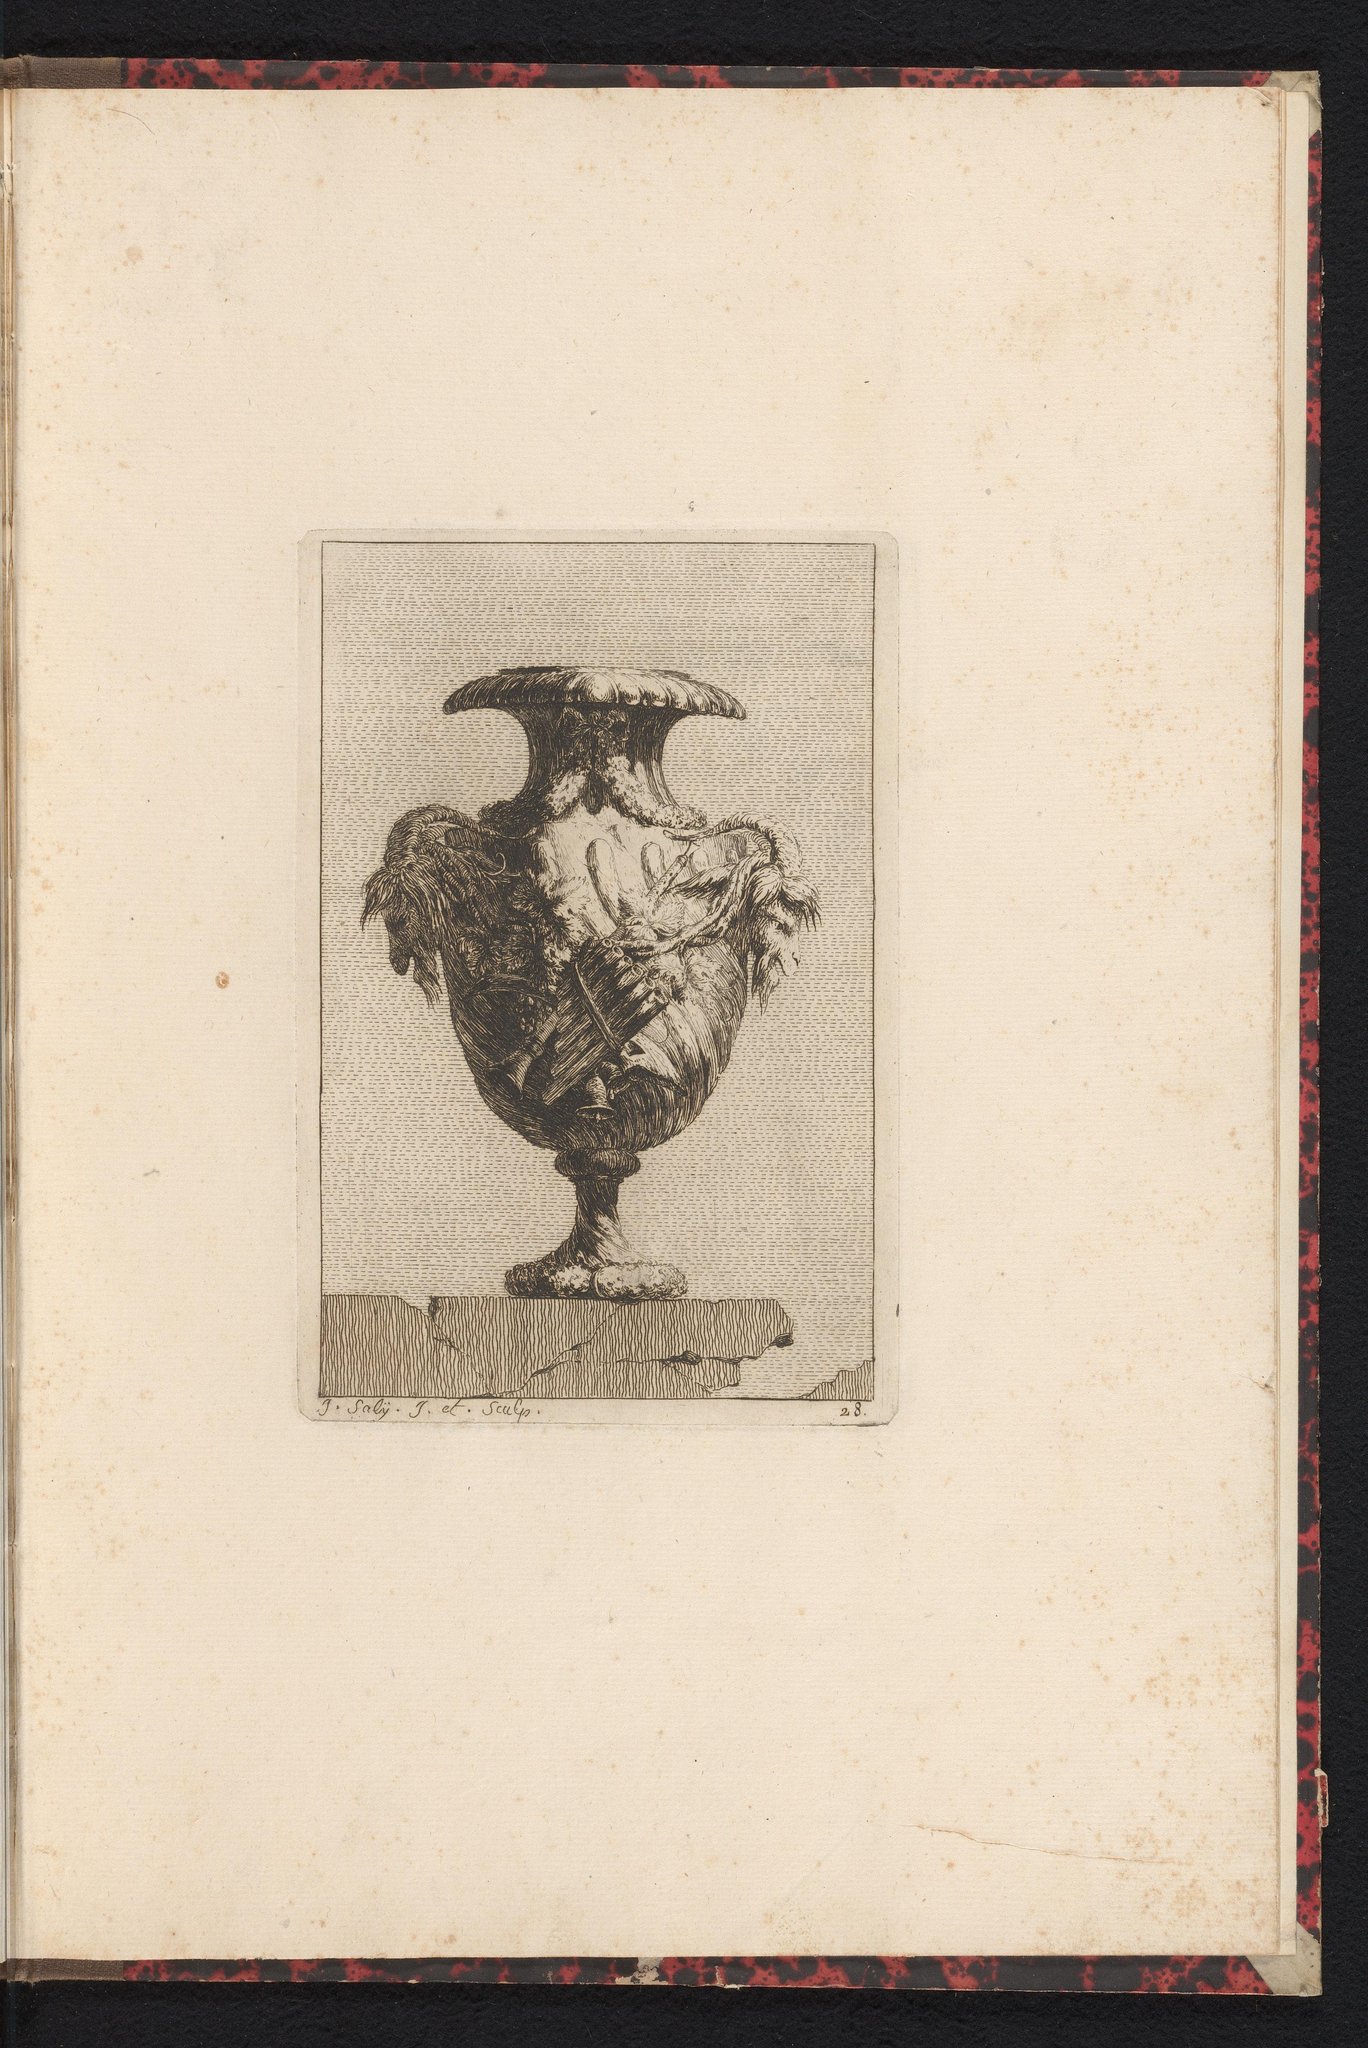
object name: ornament print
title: Vasa a se inventa atq. studii causa delin. et incisa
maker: jacques francois joseph saly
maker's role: print maker, sculptor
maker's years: 1717-1776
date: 1746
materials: paper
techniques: etching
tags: ram's head ~ ornament, panpipes, clarinet, bassoon, oboe, shawm, garden vase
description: De instrumenten zijn een panfluit en een klarinet, met daaronder bellen. Deze prent maakt deel uit van een album.